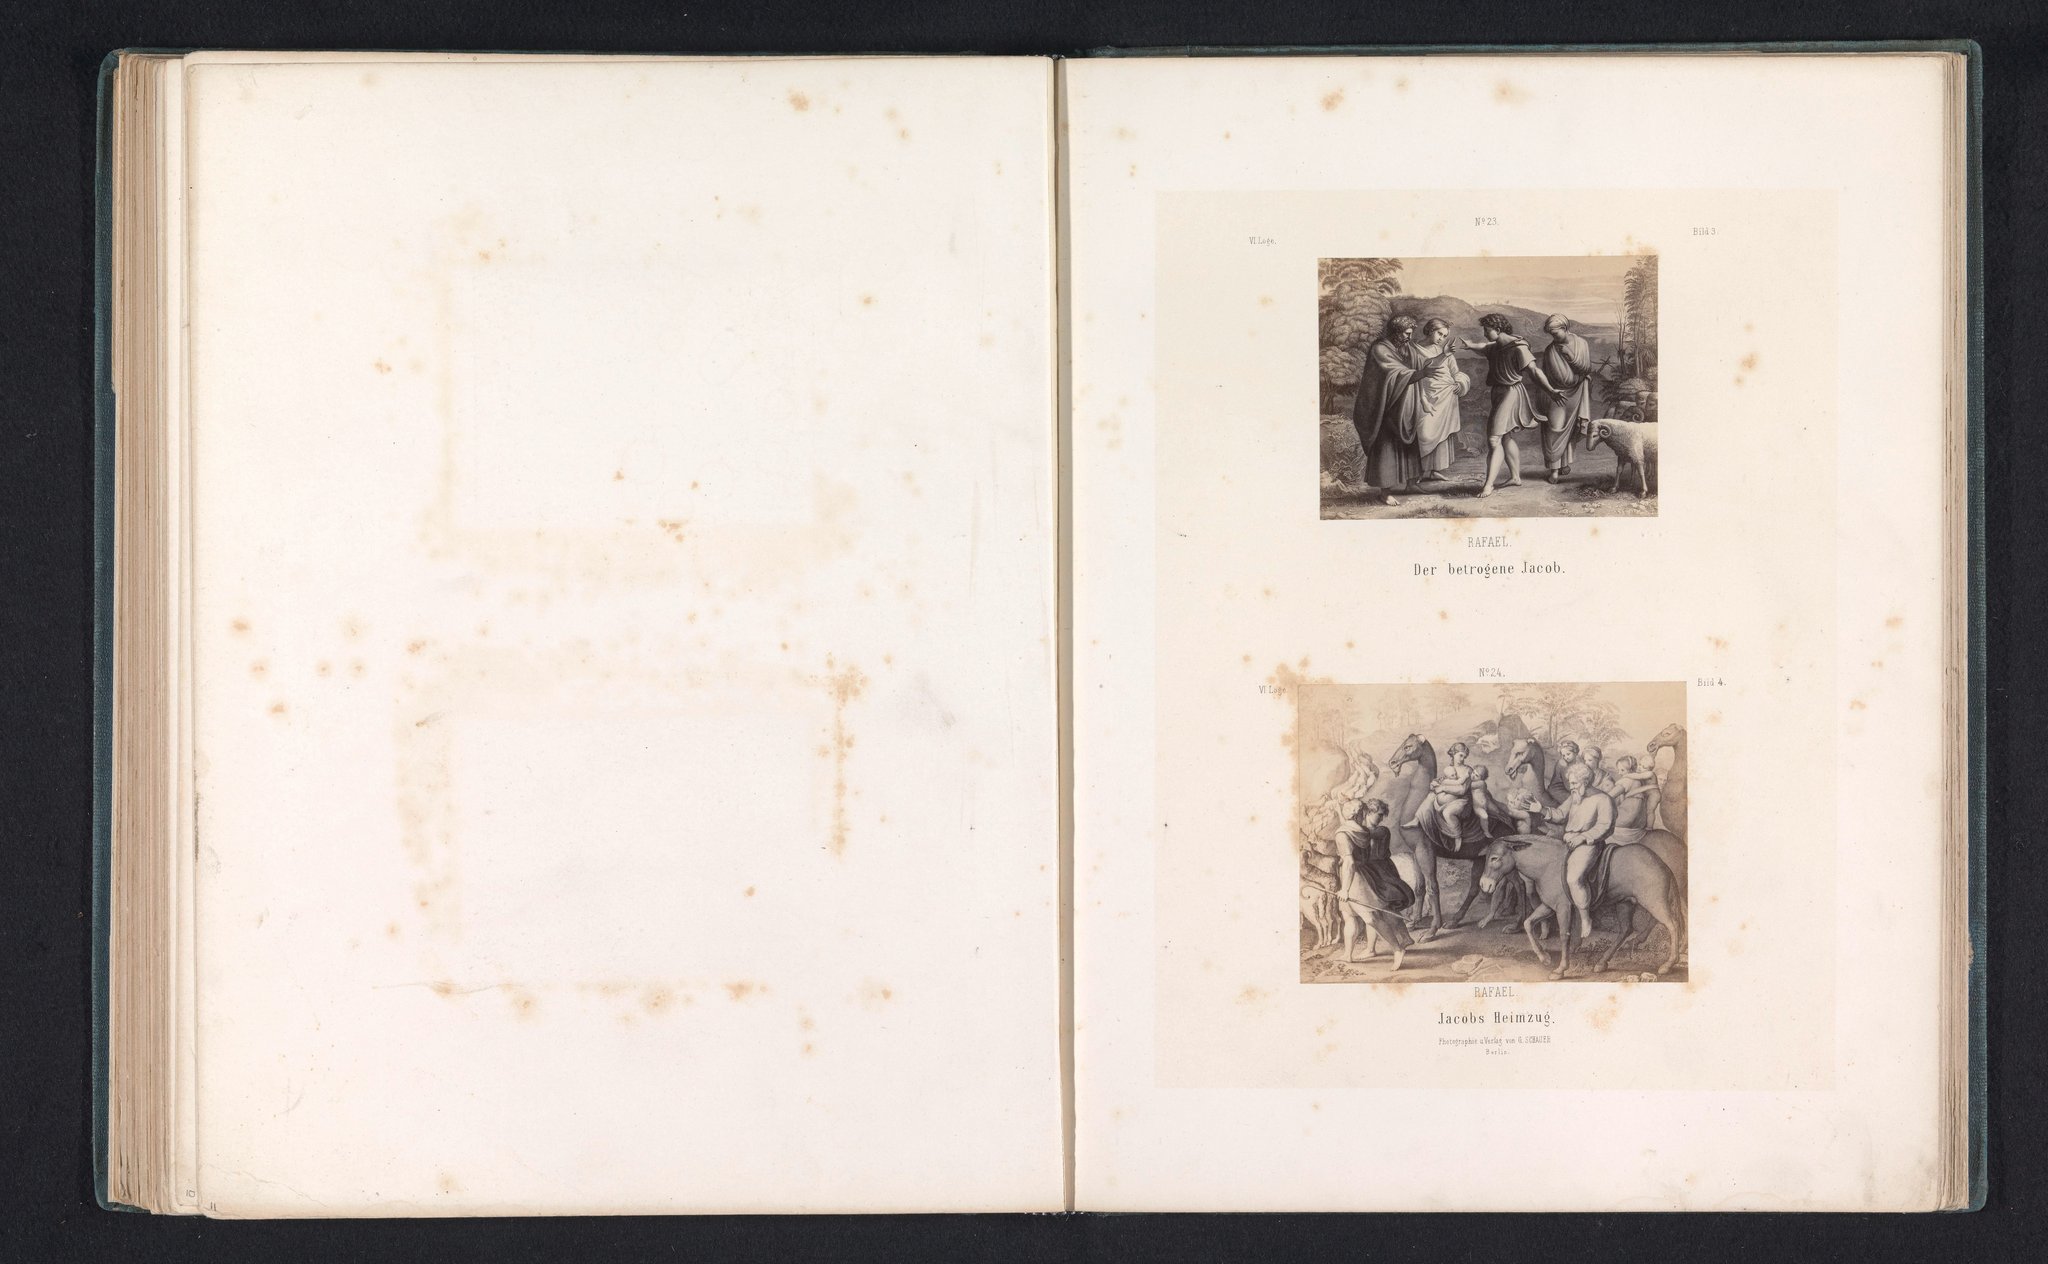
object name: reproduction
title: Fotoreproducties van prenten naar fresco's met voorstellingen van Jacob door Rafaël voor de loggia's in het Vaticaan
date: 1851-1861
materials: photographic support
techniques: albumen print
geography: berlin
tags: story of jacob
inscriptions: number: ‘No 23. No 24. Bild 3. Bild 4. VI. Loge.’